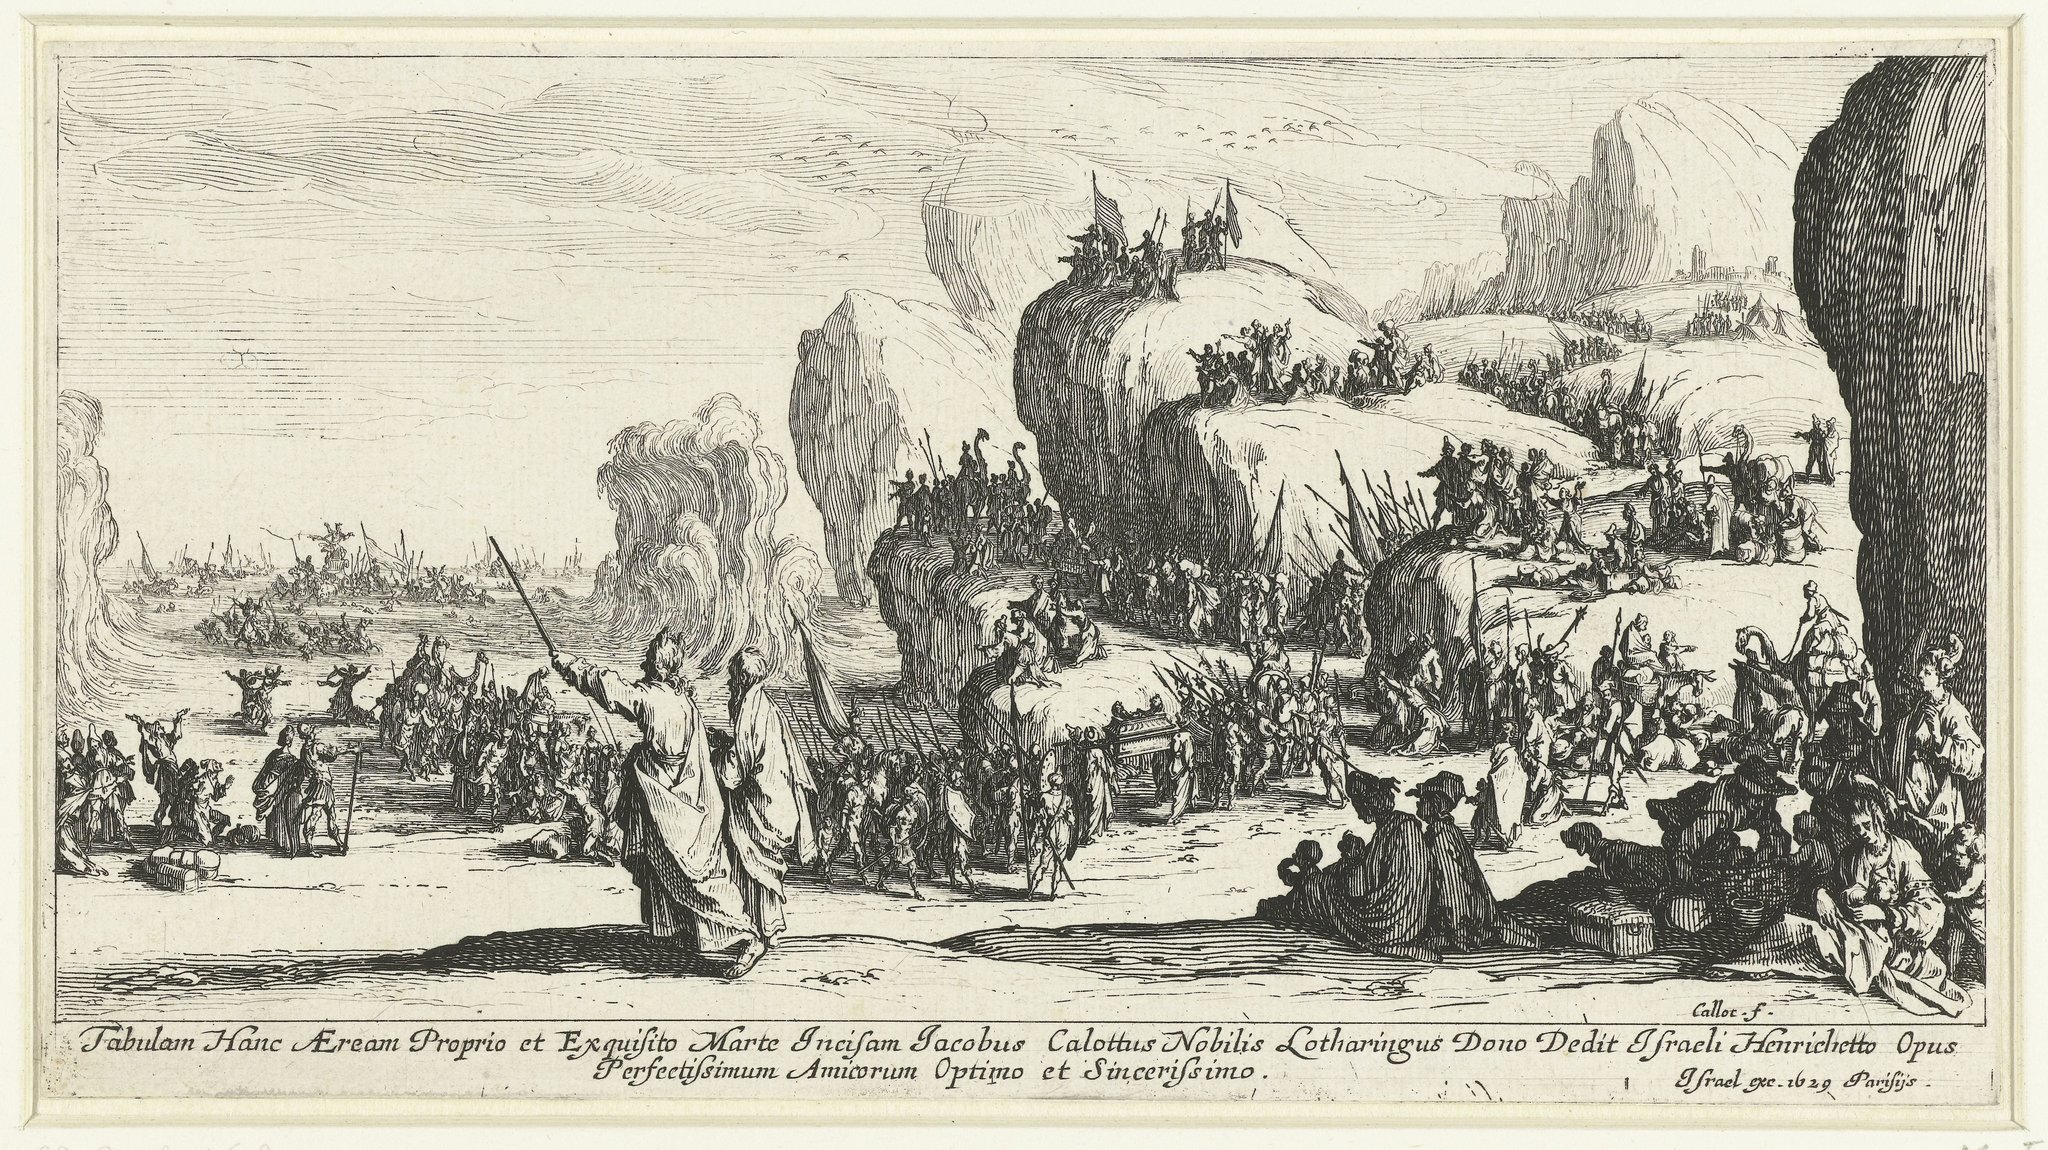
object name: print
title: De doortocht door de Rode Zee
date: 1629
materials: paper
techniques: etching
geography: nancy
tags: with his people safe on the shore, moses raises his hands and causes the water to return; pharaoh's army perishes in the water (red sea)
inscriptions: collector's mark: Lugt 240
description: Op de voorgrond staan Mozes en Aäron, eerstgenoemde met een staf in de geheven linkerhand. Voor hen langs trekken de Israëlieten tussen de geweken golven van de Schelfzee (een uitloper van de Rode Zee) door en verder door de bergen. Links op de achtergrond is te zien hoe de farao met zijn gevolg verzwolgen wordt door het terugvloeiende water. Onder de voorstelling twee regels Latijnse tekst.